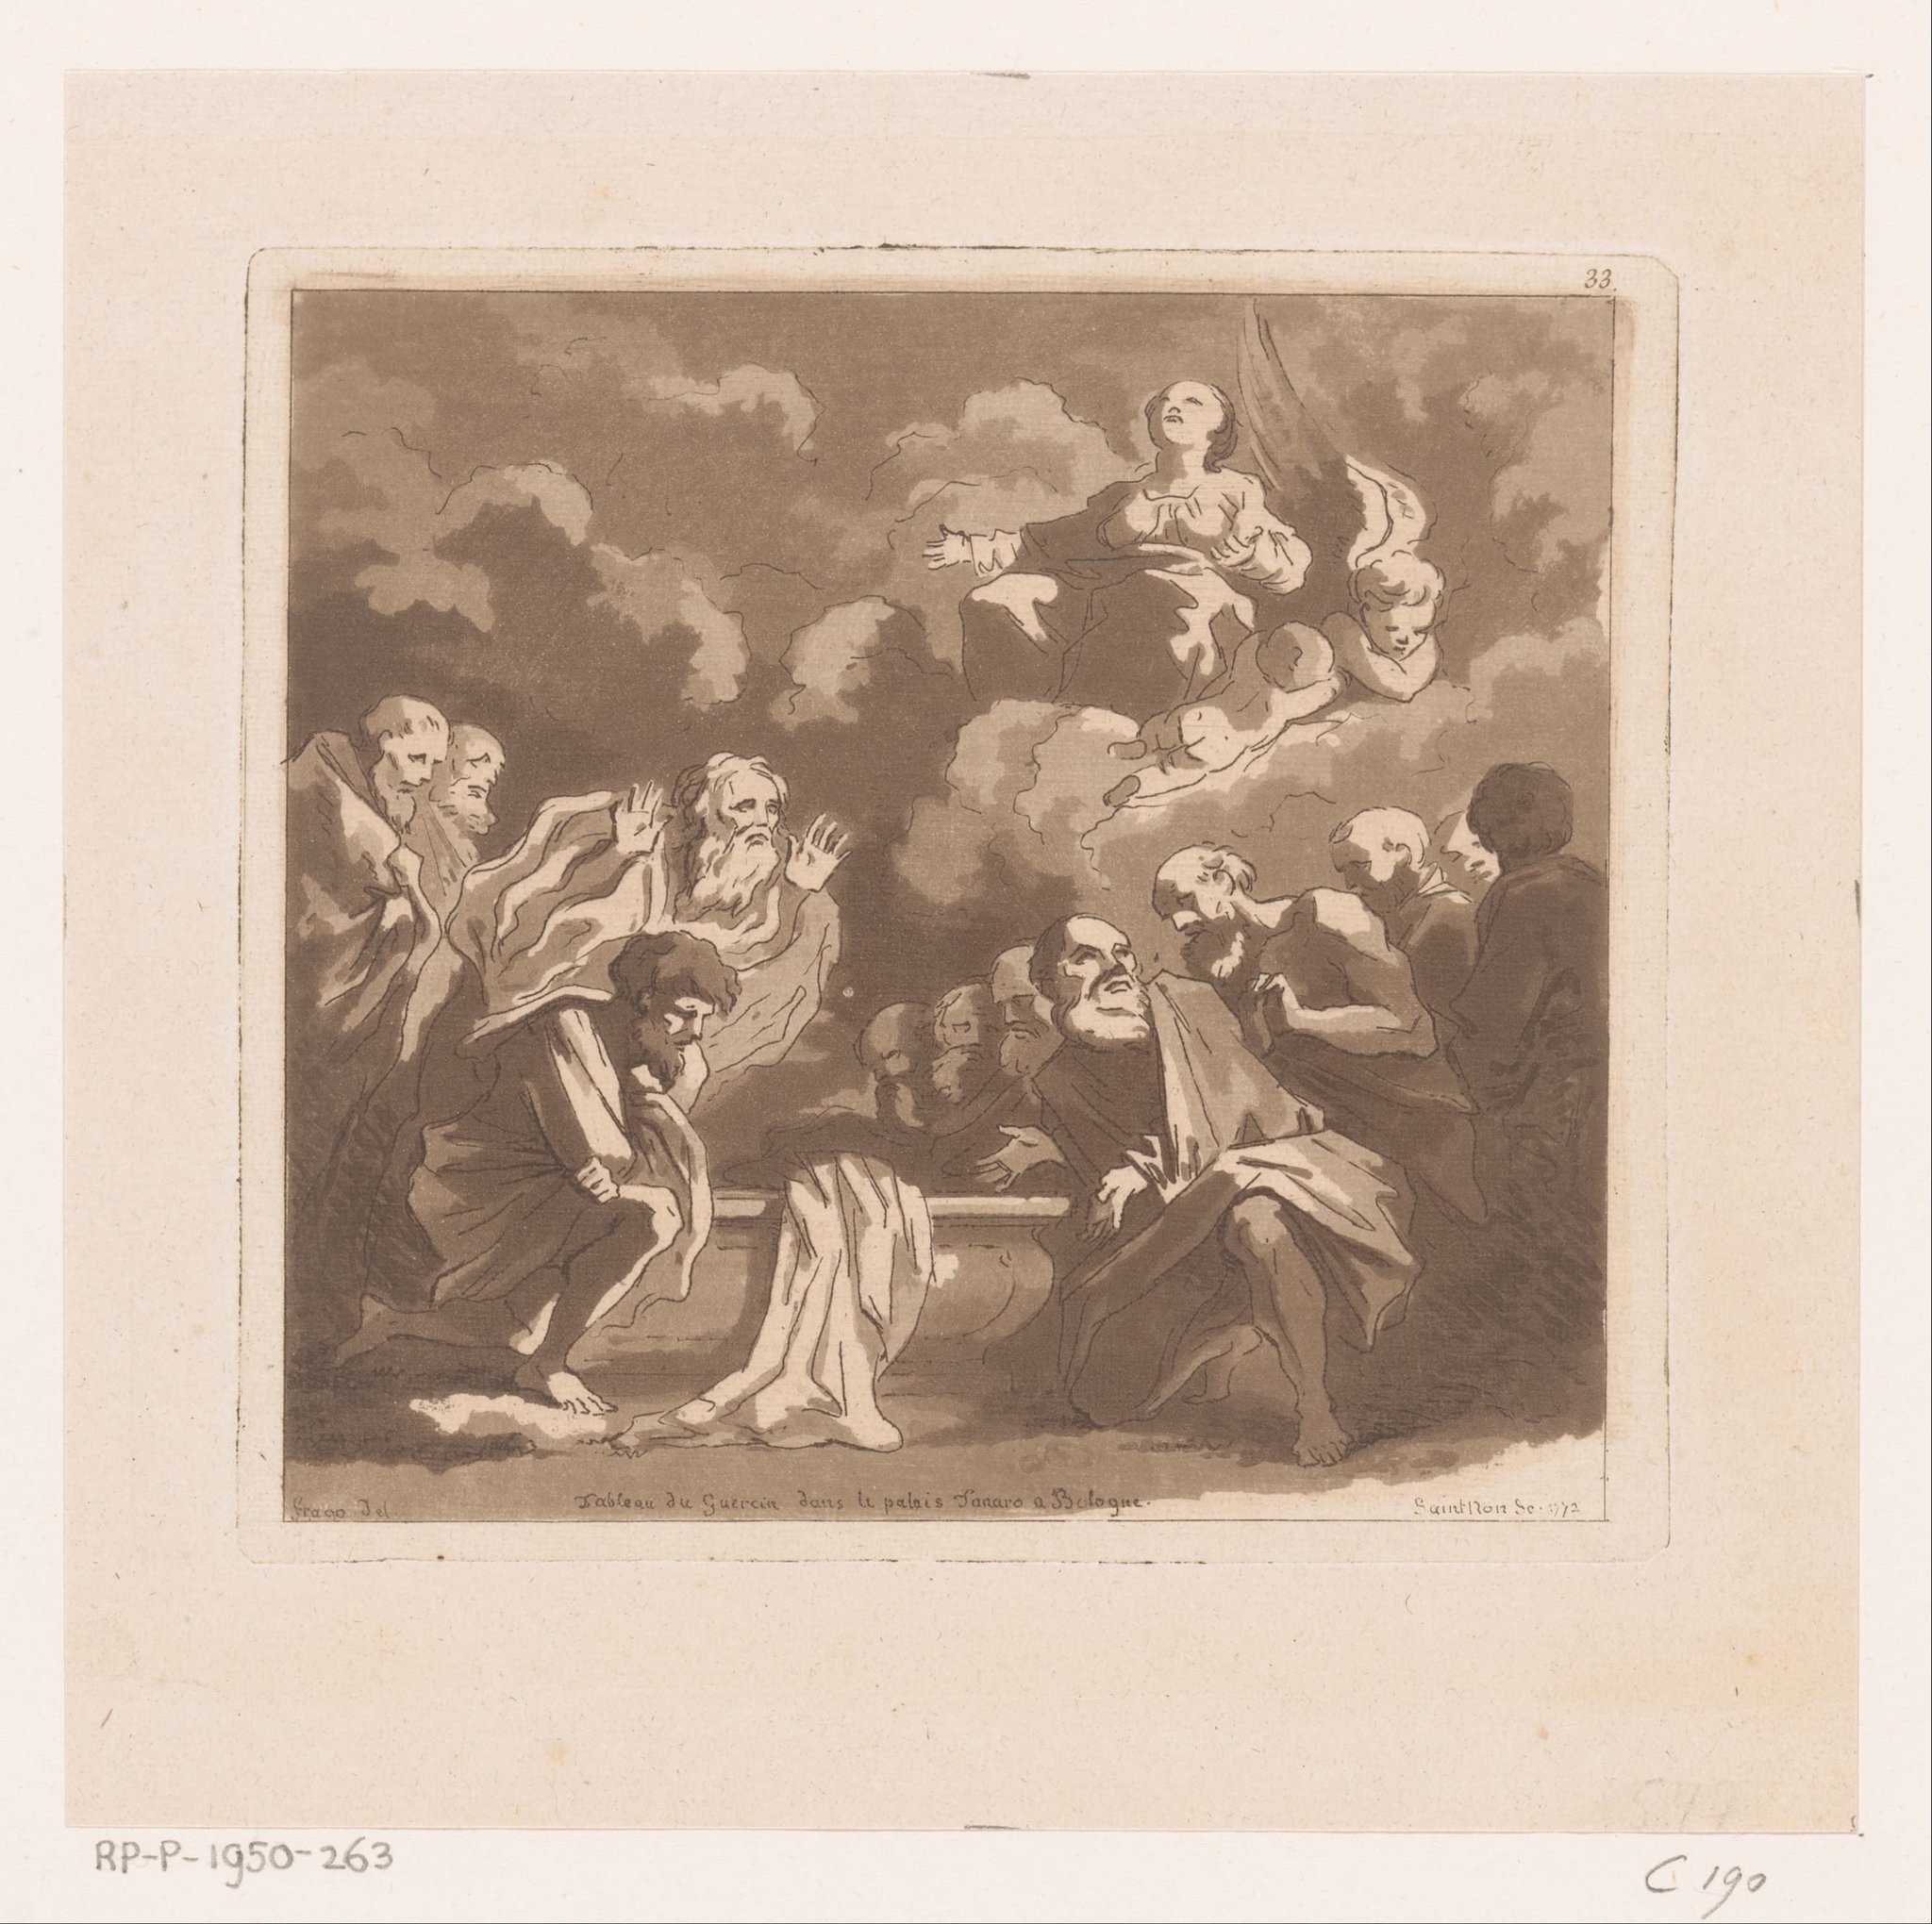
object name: print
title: Fragments choisis dans les peintures et les tableaux les plus intéressants de l'Italie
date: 1772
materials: paper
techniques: aquatint, etching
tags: the assumption of mary ('assumptio corporis'): she is borne into heaven by angels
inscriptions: collector's mark: Lugt 2228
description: Prent maakt deel uit van een serie met daarbinnen delen over specifiek Rome, Bologna, Napels en Venetië.